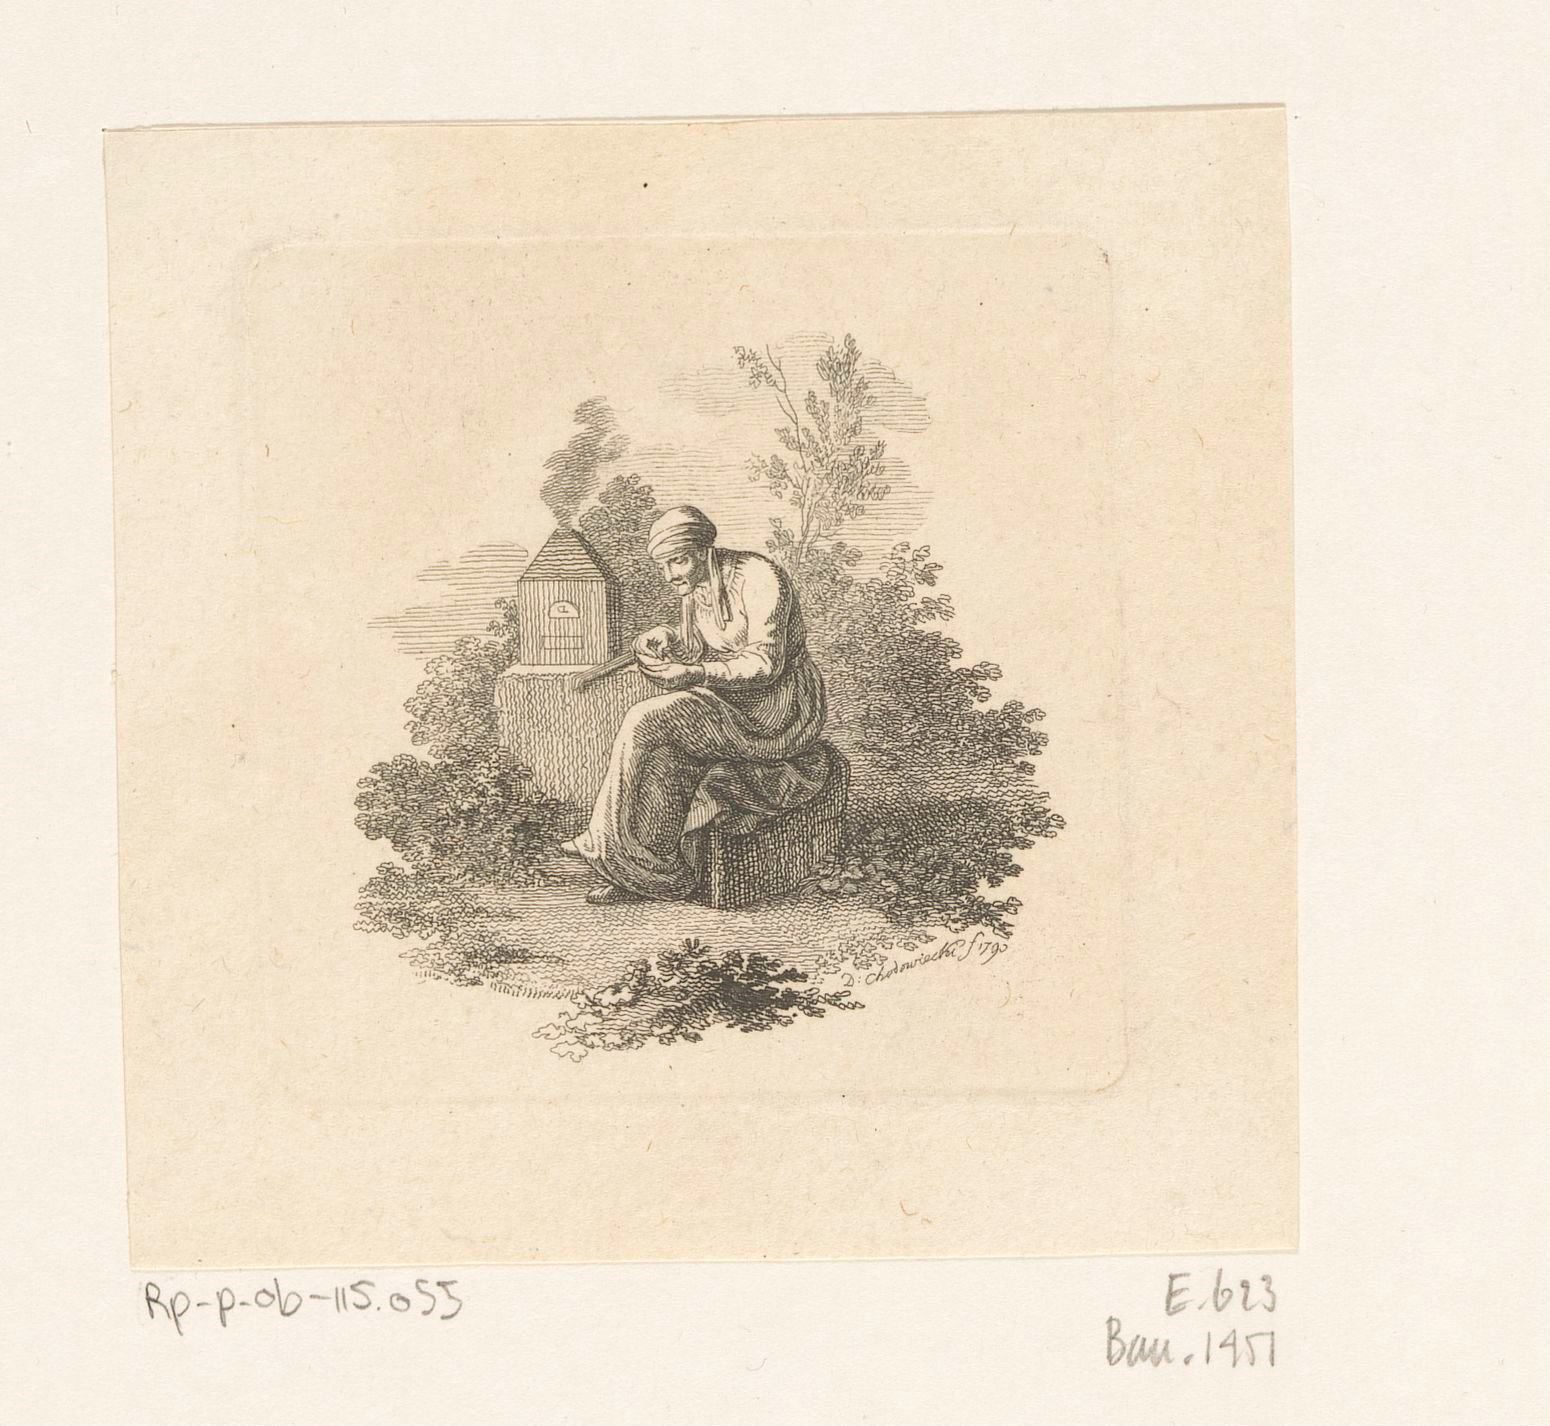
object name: print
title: Vrouw zittend naast een oven voor natuurwetenschappelijke proeven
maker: daniel nikolaus chodowiecki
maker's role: draughtsman, print maker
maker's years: 1726-1801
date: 1790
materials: paper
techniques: etching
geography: berlin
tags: germany, landscapes, alchemistic furnace, old woman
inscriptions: collector's mark: Lugt 2228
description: Prent gebruikt voor: Büsch, Johann Georg. Erfahrungen von Johann Georg Büsch, Professor in Hamburg. 2 dln. Hamburg: Benjamin Gottlob Hoffmann, 1790, dl. 2.